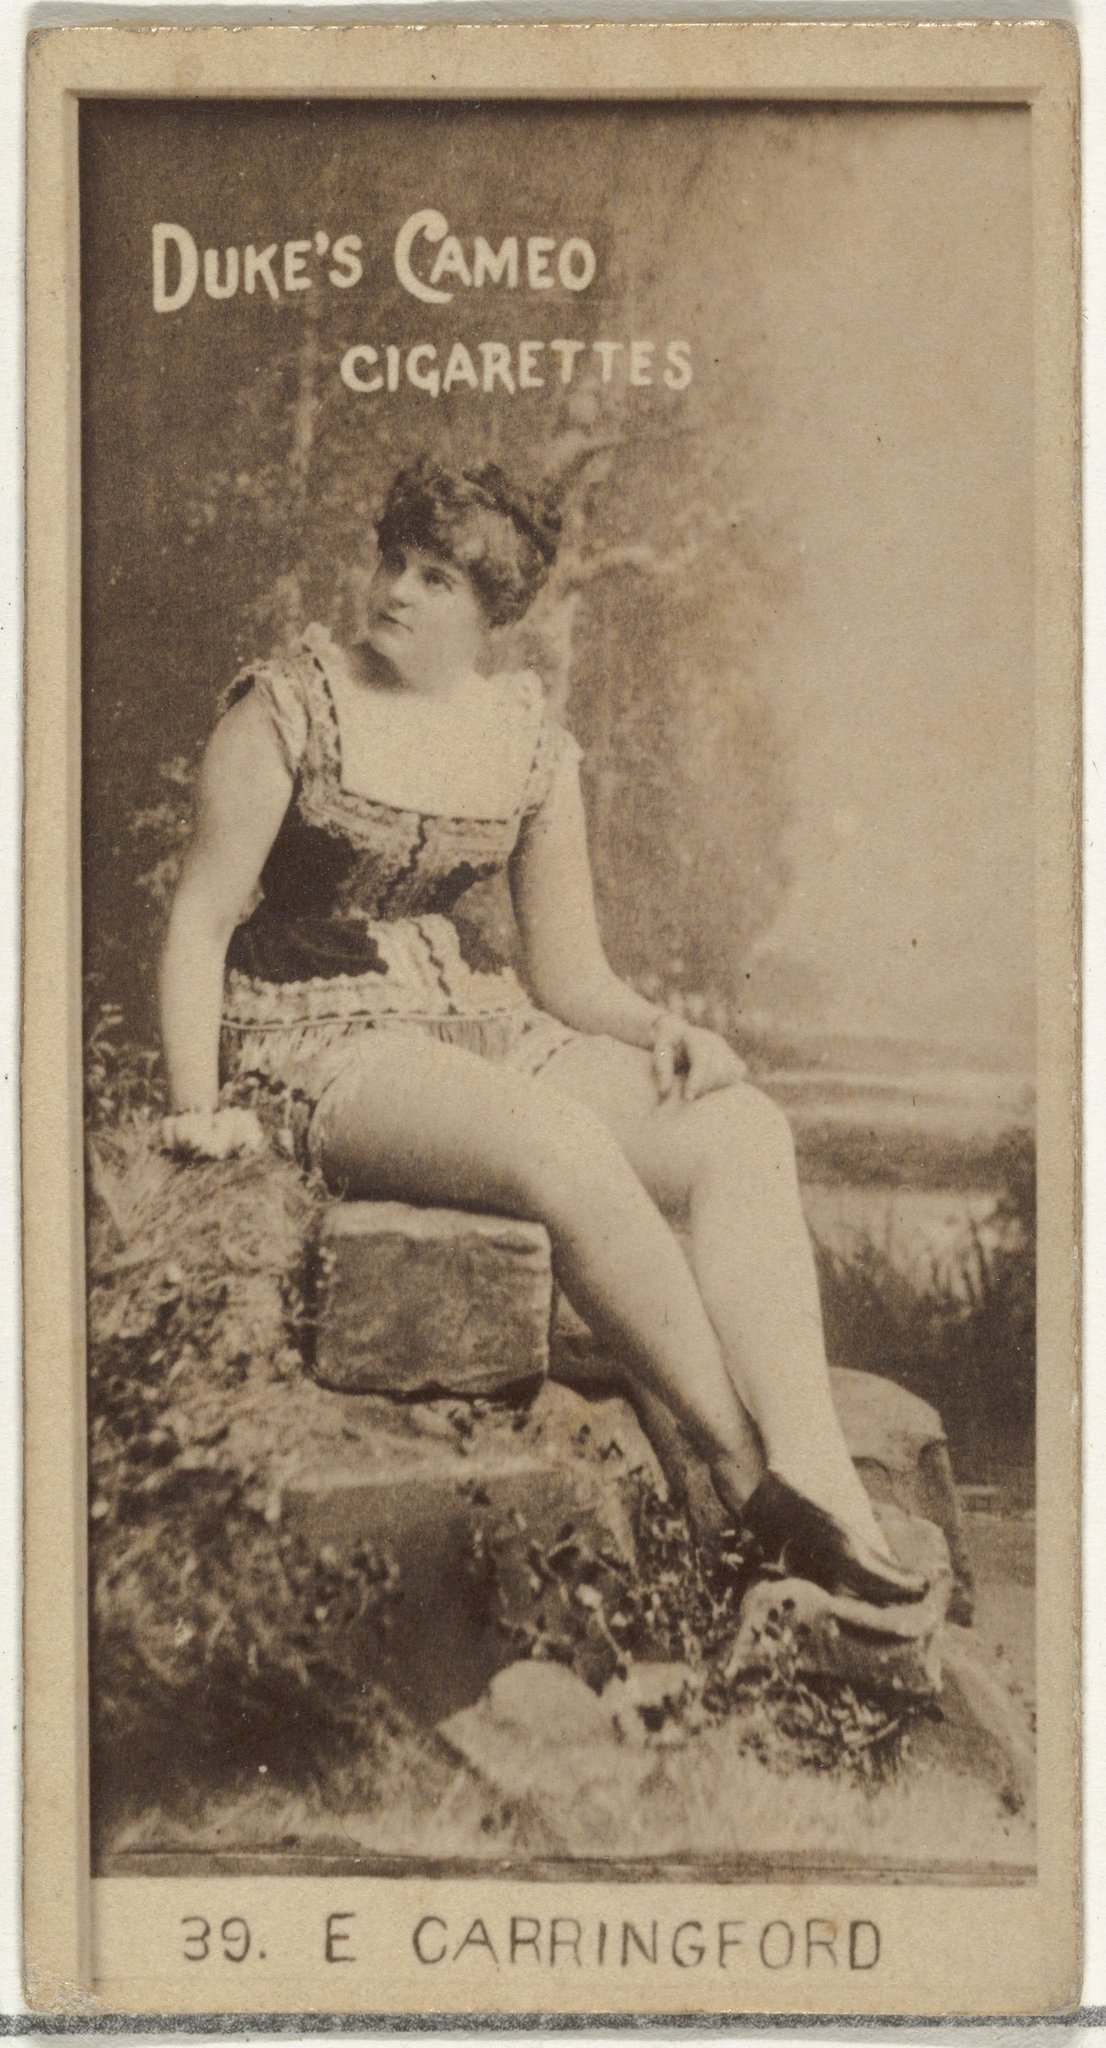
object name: photograph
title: Card Number 39, E. Carringford, from the Actors and Actresses series (N145-4) issued by Duke Sons & Co. to promote Cameo Cigarettes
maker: w. duke, sons & co.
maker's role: publisher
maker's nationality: american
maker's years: 1870-1920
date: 1880-1889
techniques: albumen silver print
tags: portraits,women,actresses